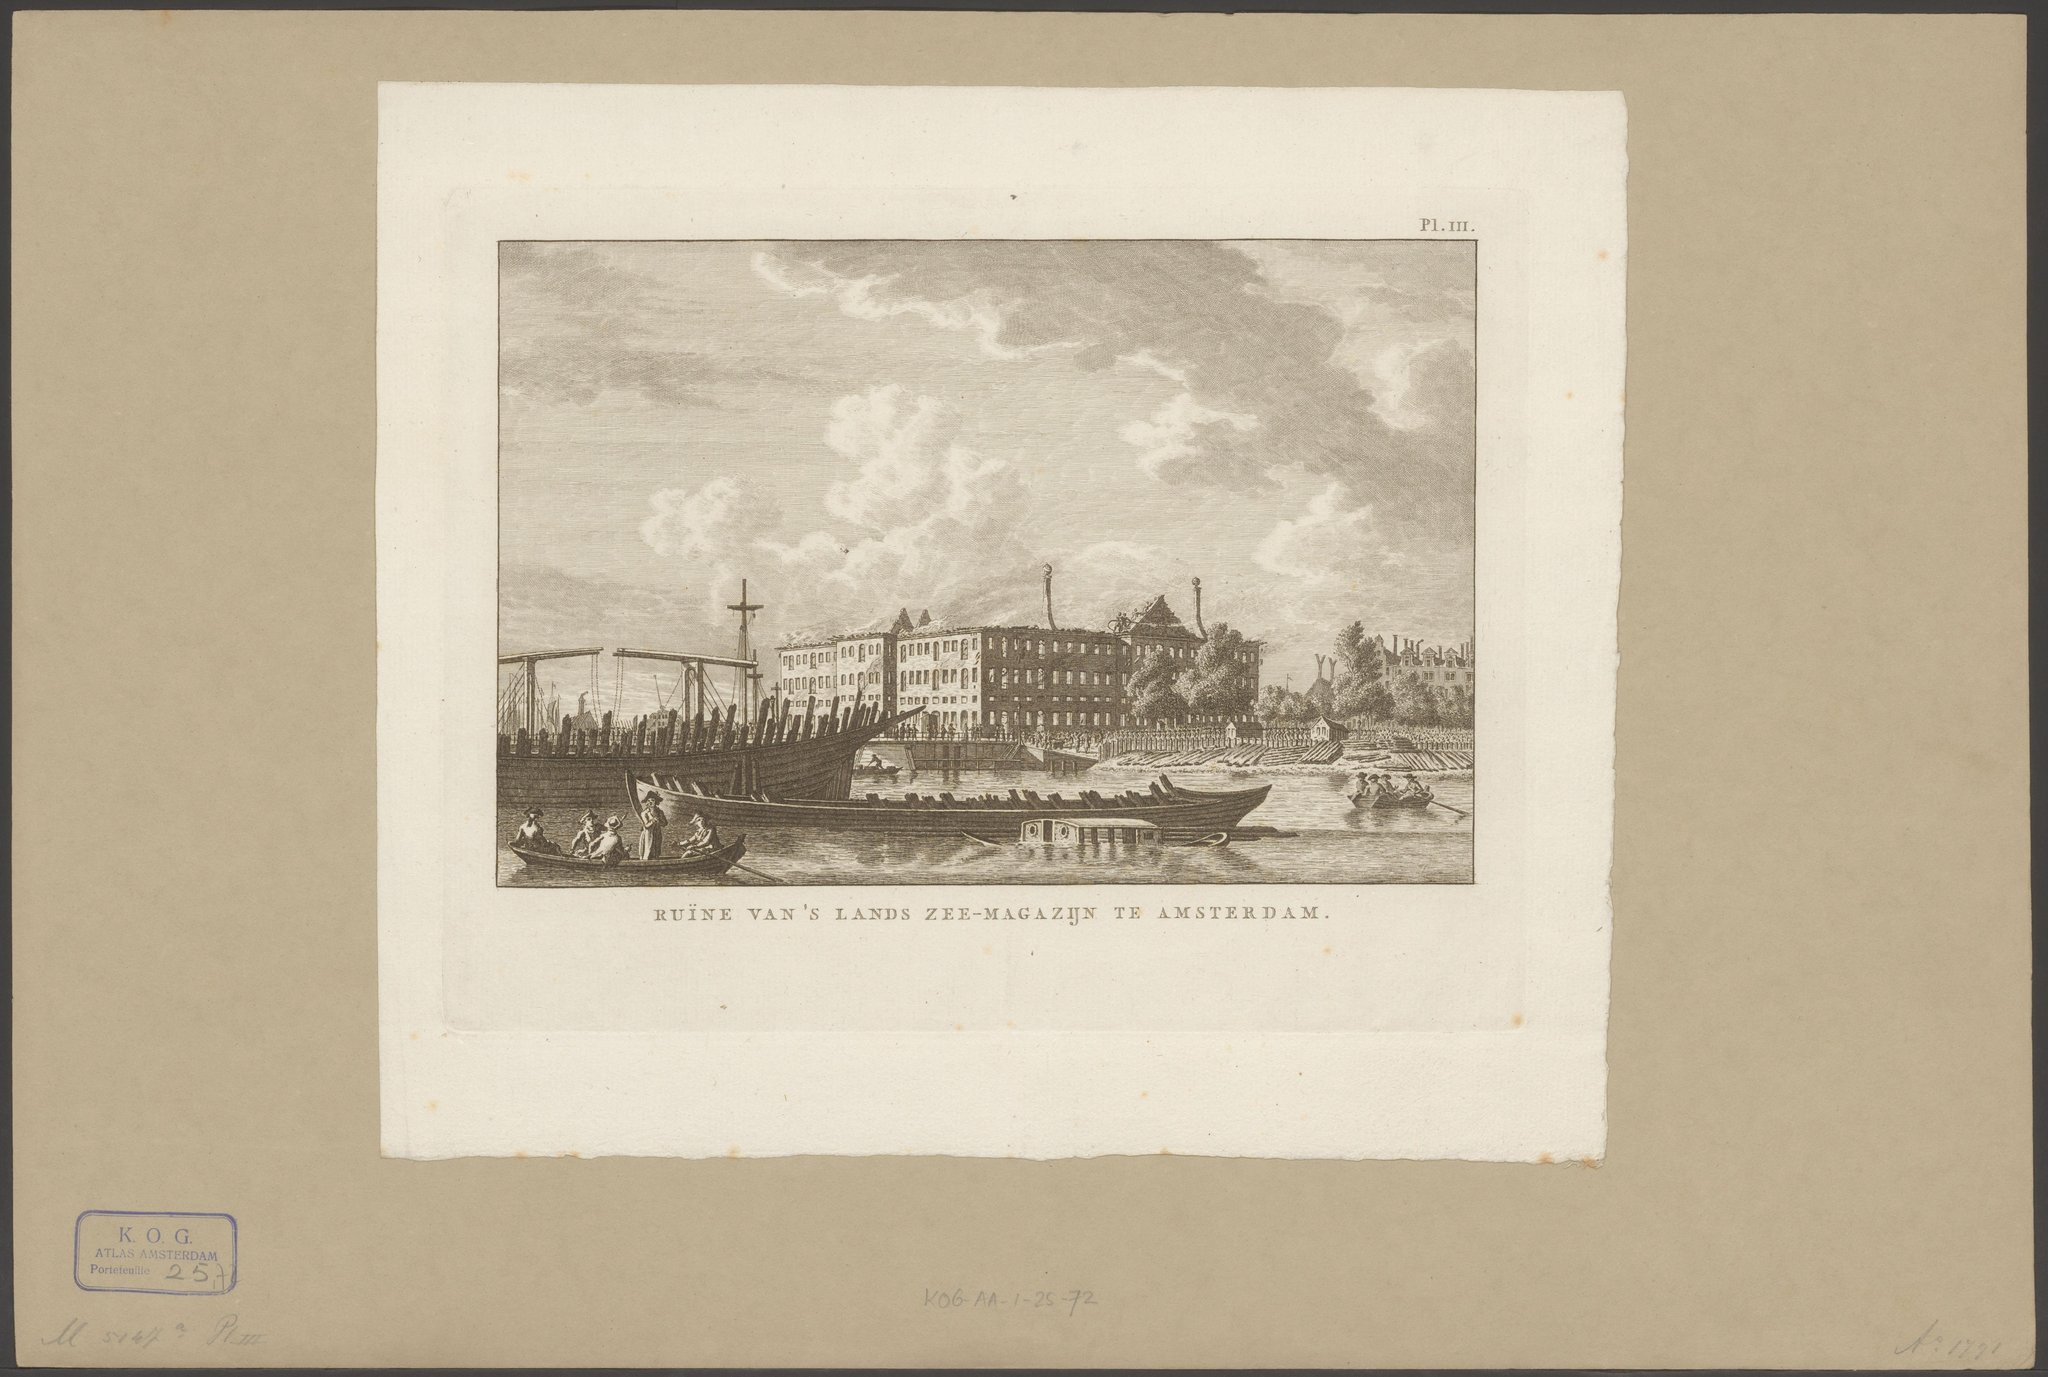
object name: print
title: 's Lands Zeemagazijn in welstand, tijdens en na de brand in 1791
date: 1791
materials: paper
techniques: engraving, etching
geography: northern netherlands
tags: large-scale structure for storage, e.g.: warehouse, depot, silo, on fire, ablaze, ruin of a building ~ architecture, ammunition store, arsenal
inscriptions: collector's mark: ‘25.72’ Lugt 1641b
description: Onderdeel van een serie van drie over de brand in 1791. Rechtsboven genummerd: Pl. III. Onderwerpsrubriek binnen de Atlas Amsterdam: Krijgswezen I: De Admiraliteit van Amsterdam, A. Admiraliteitsgebouwen.